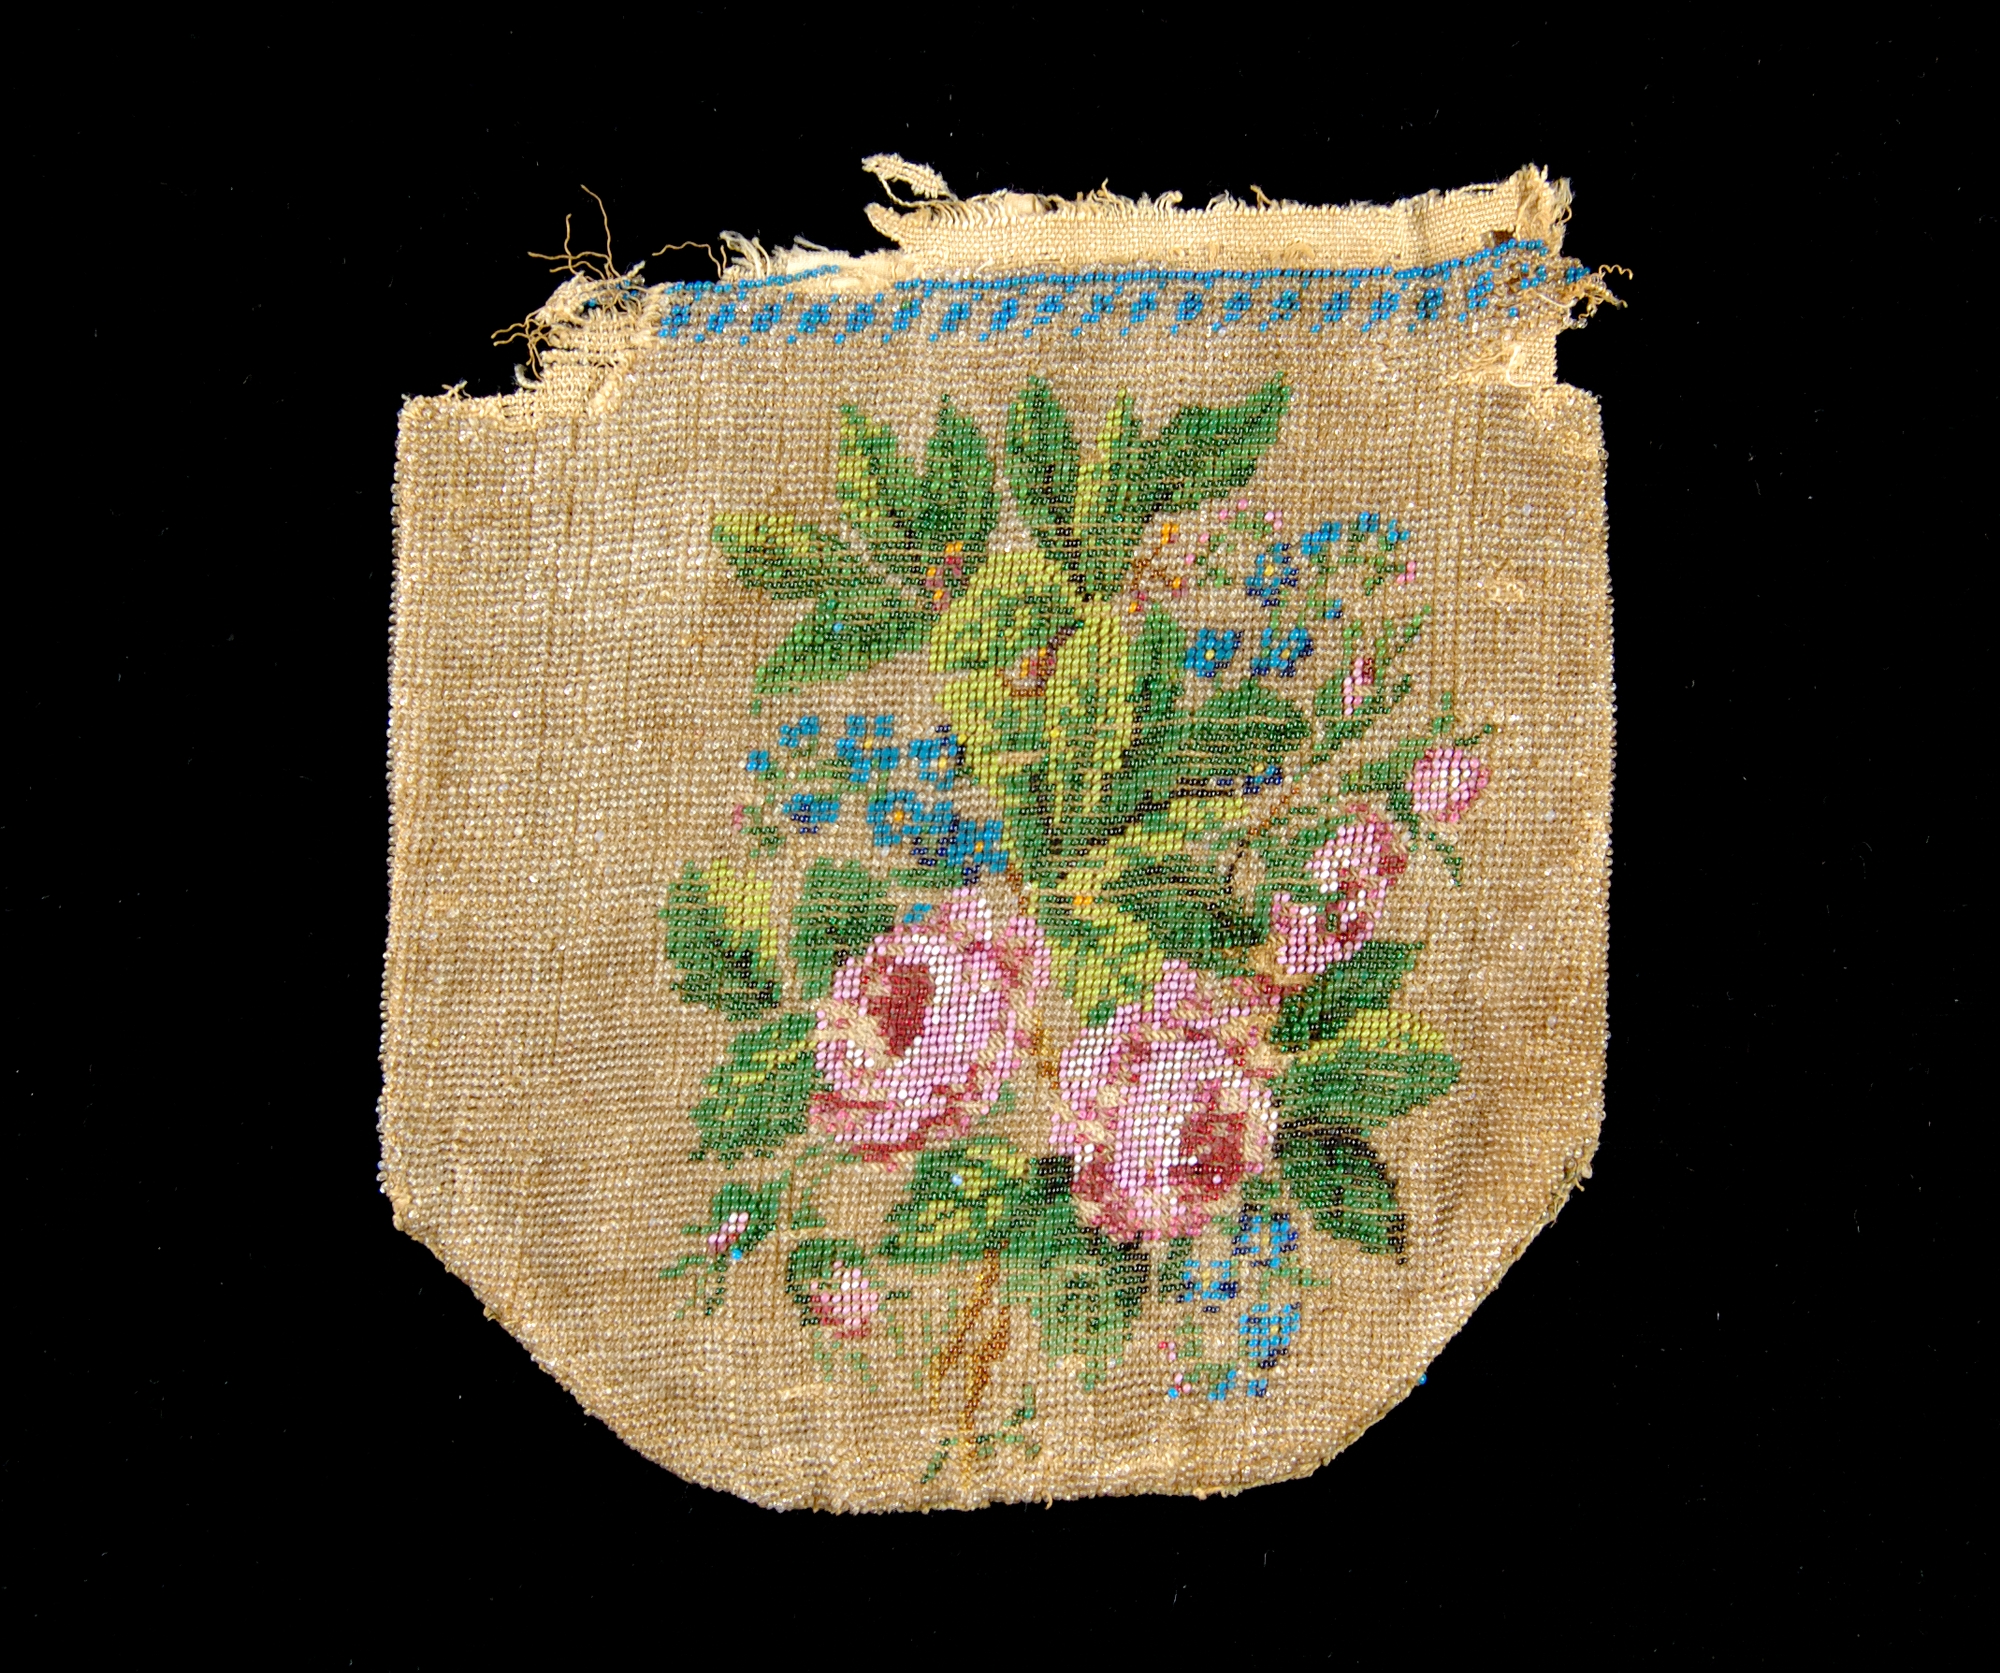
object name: pouch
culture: american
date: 1830-1860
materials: glass, linen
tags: flowers